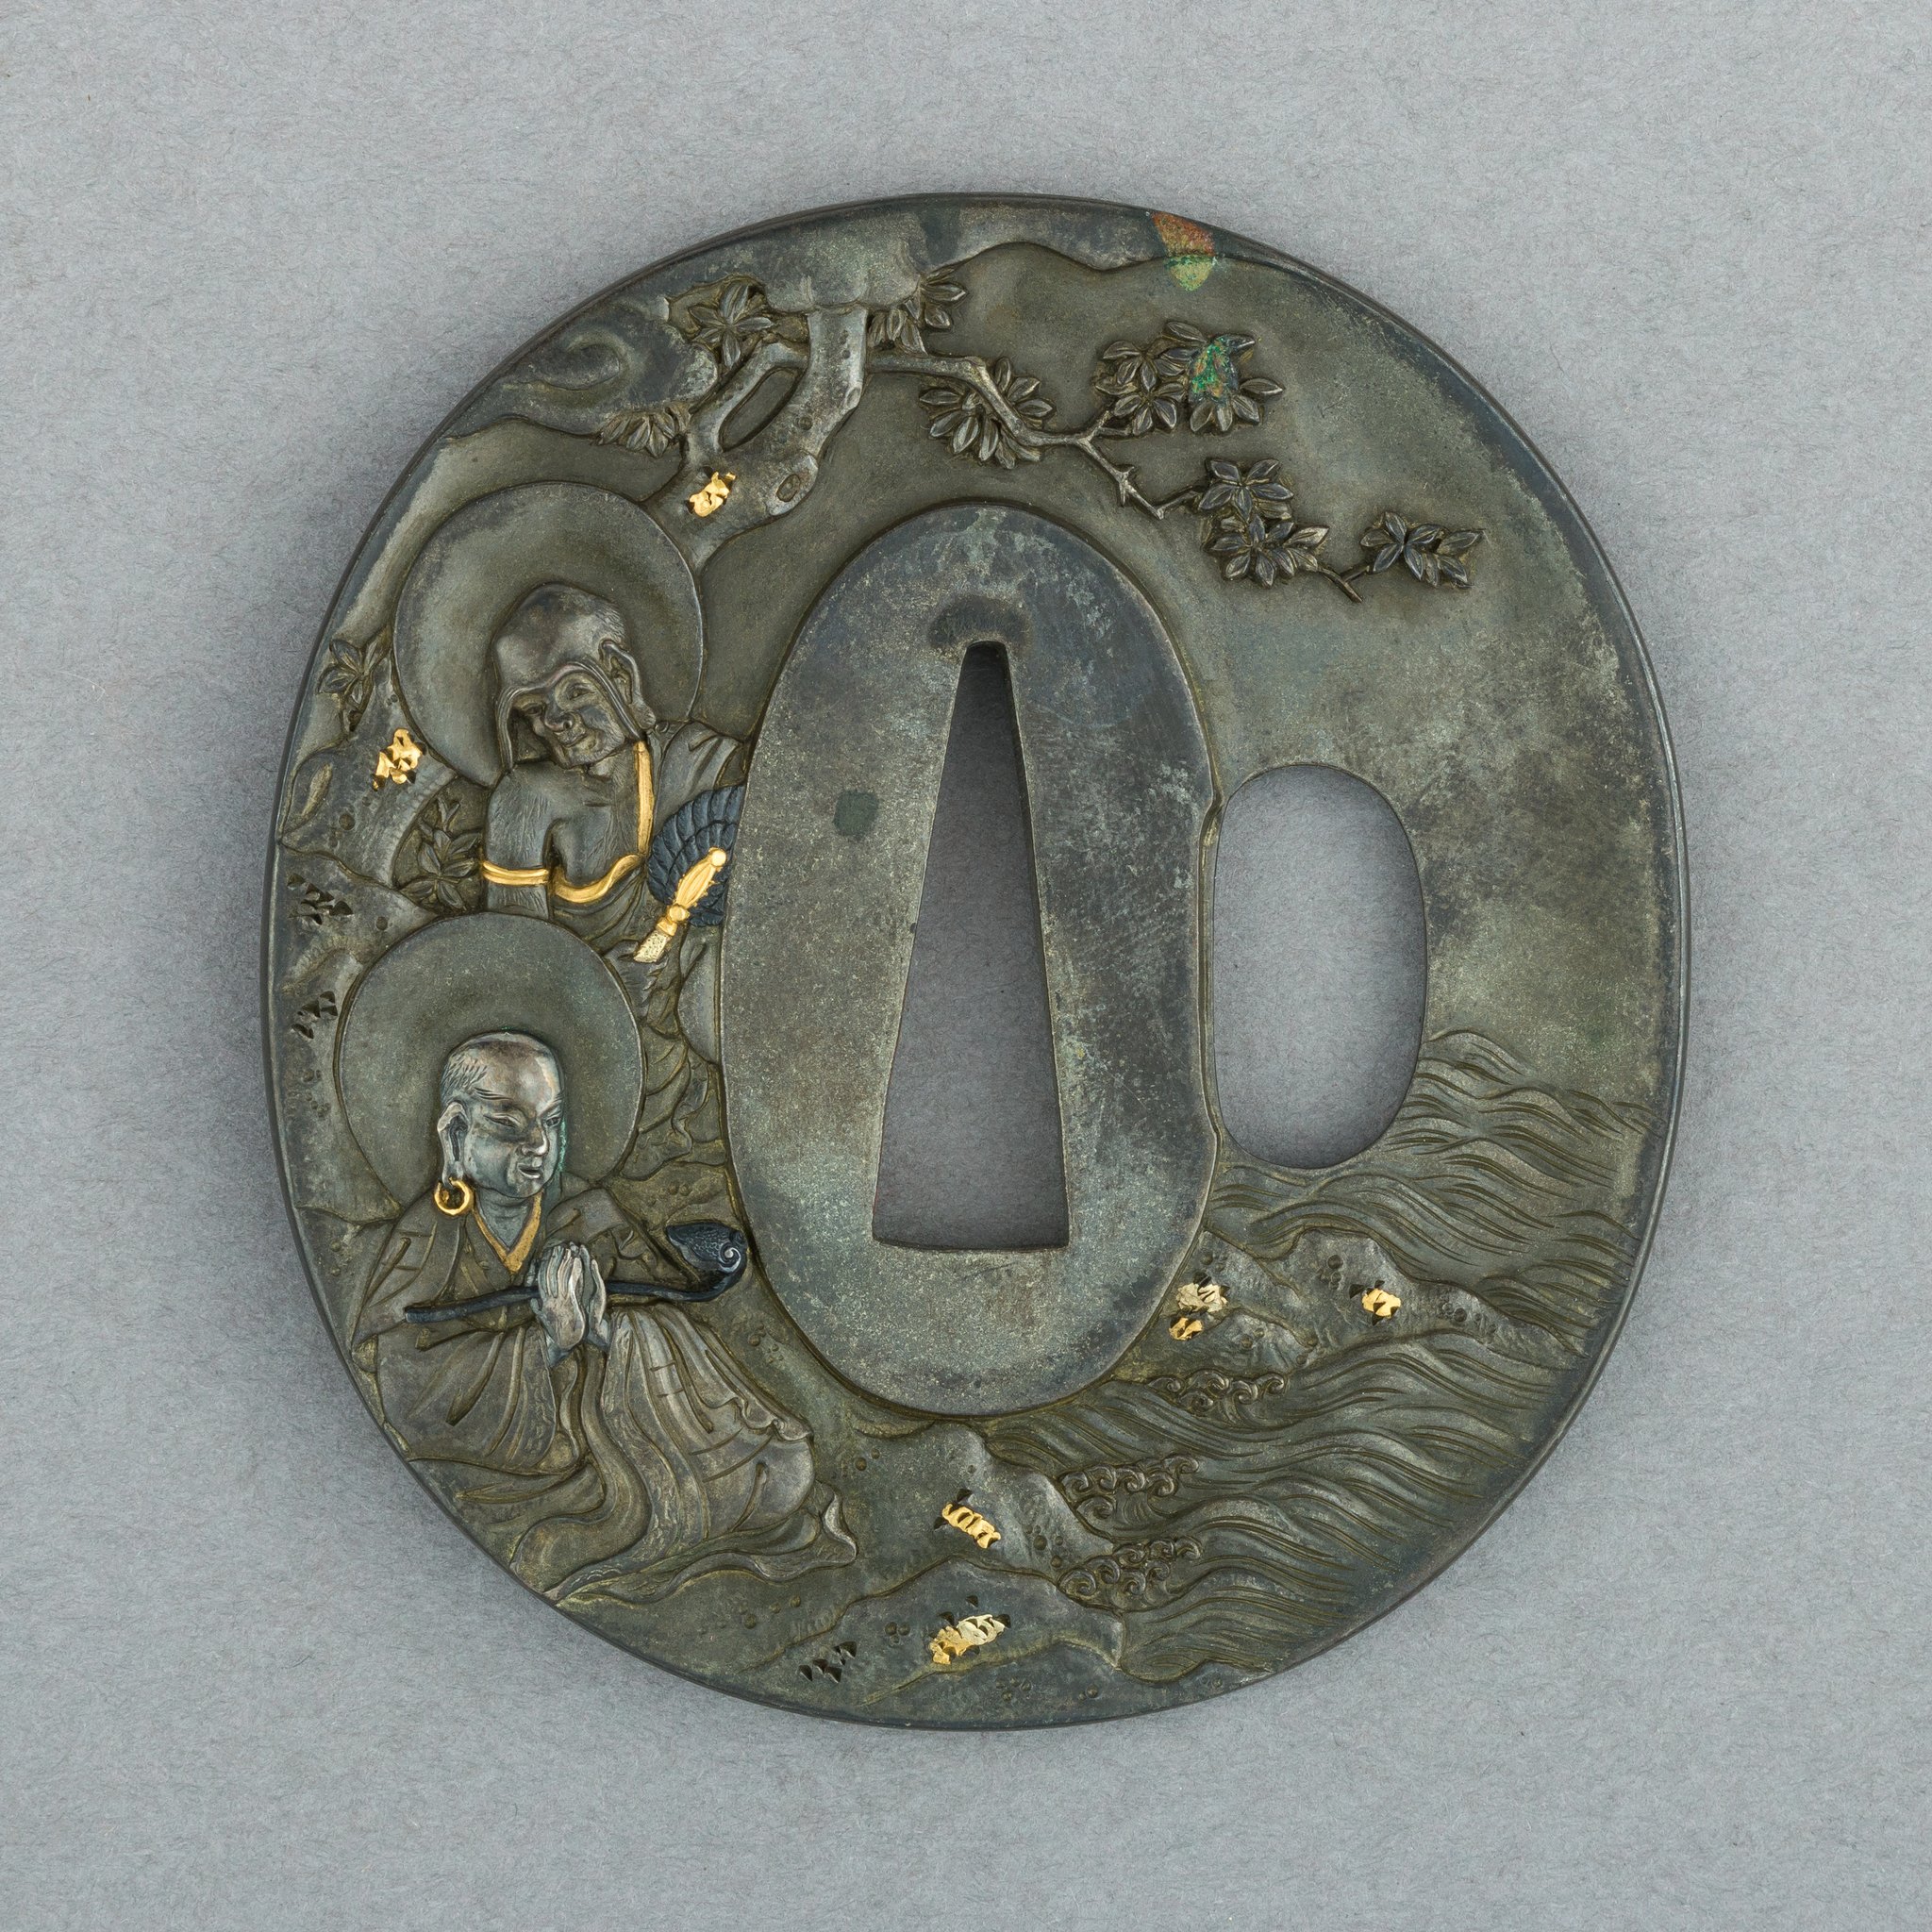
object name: sword guard tsuba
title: Sword Guard (Tsuba)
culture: japanese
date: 1615-1868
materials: gold alloy, silver alloy, gold, silver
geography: japan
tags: men